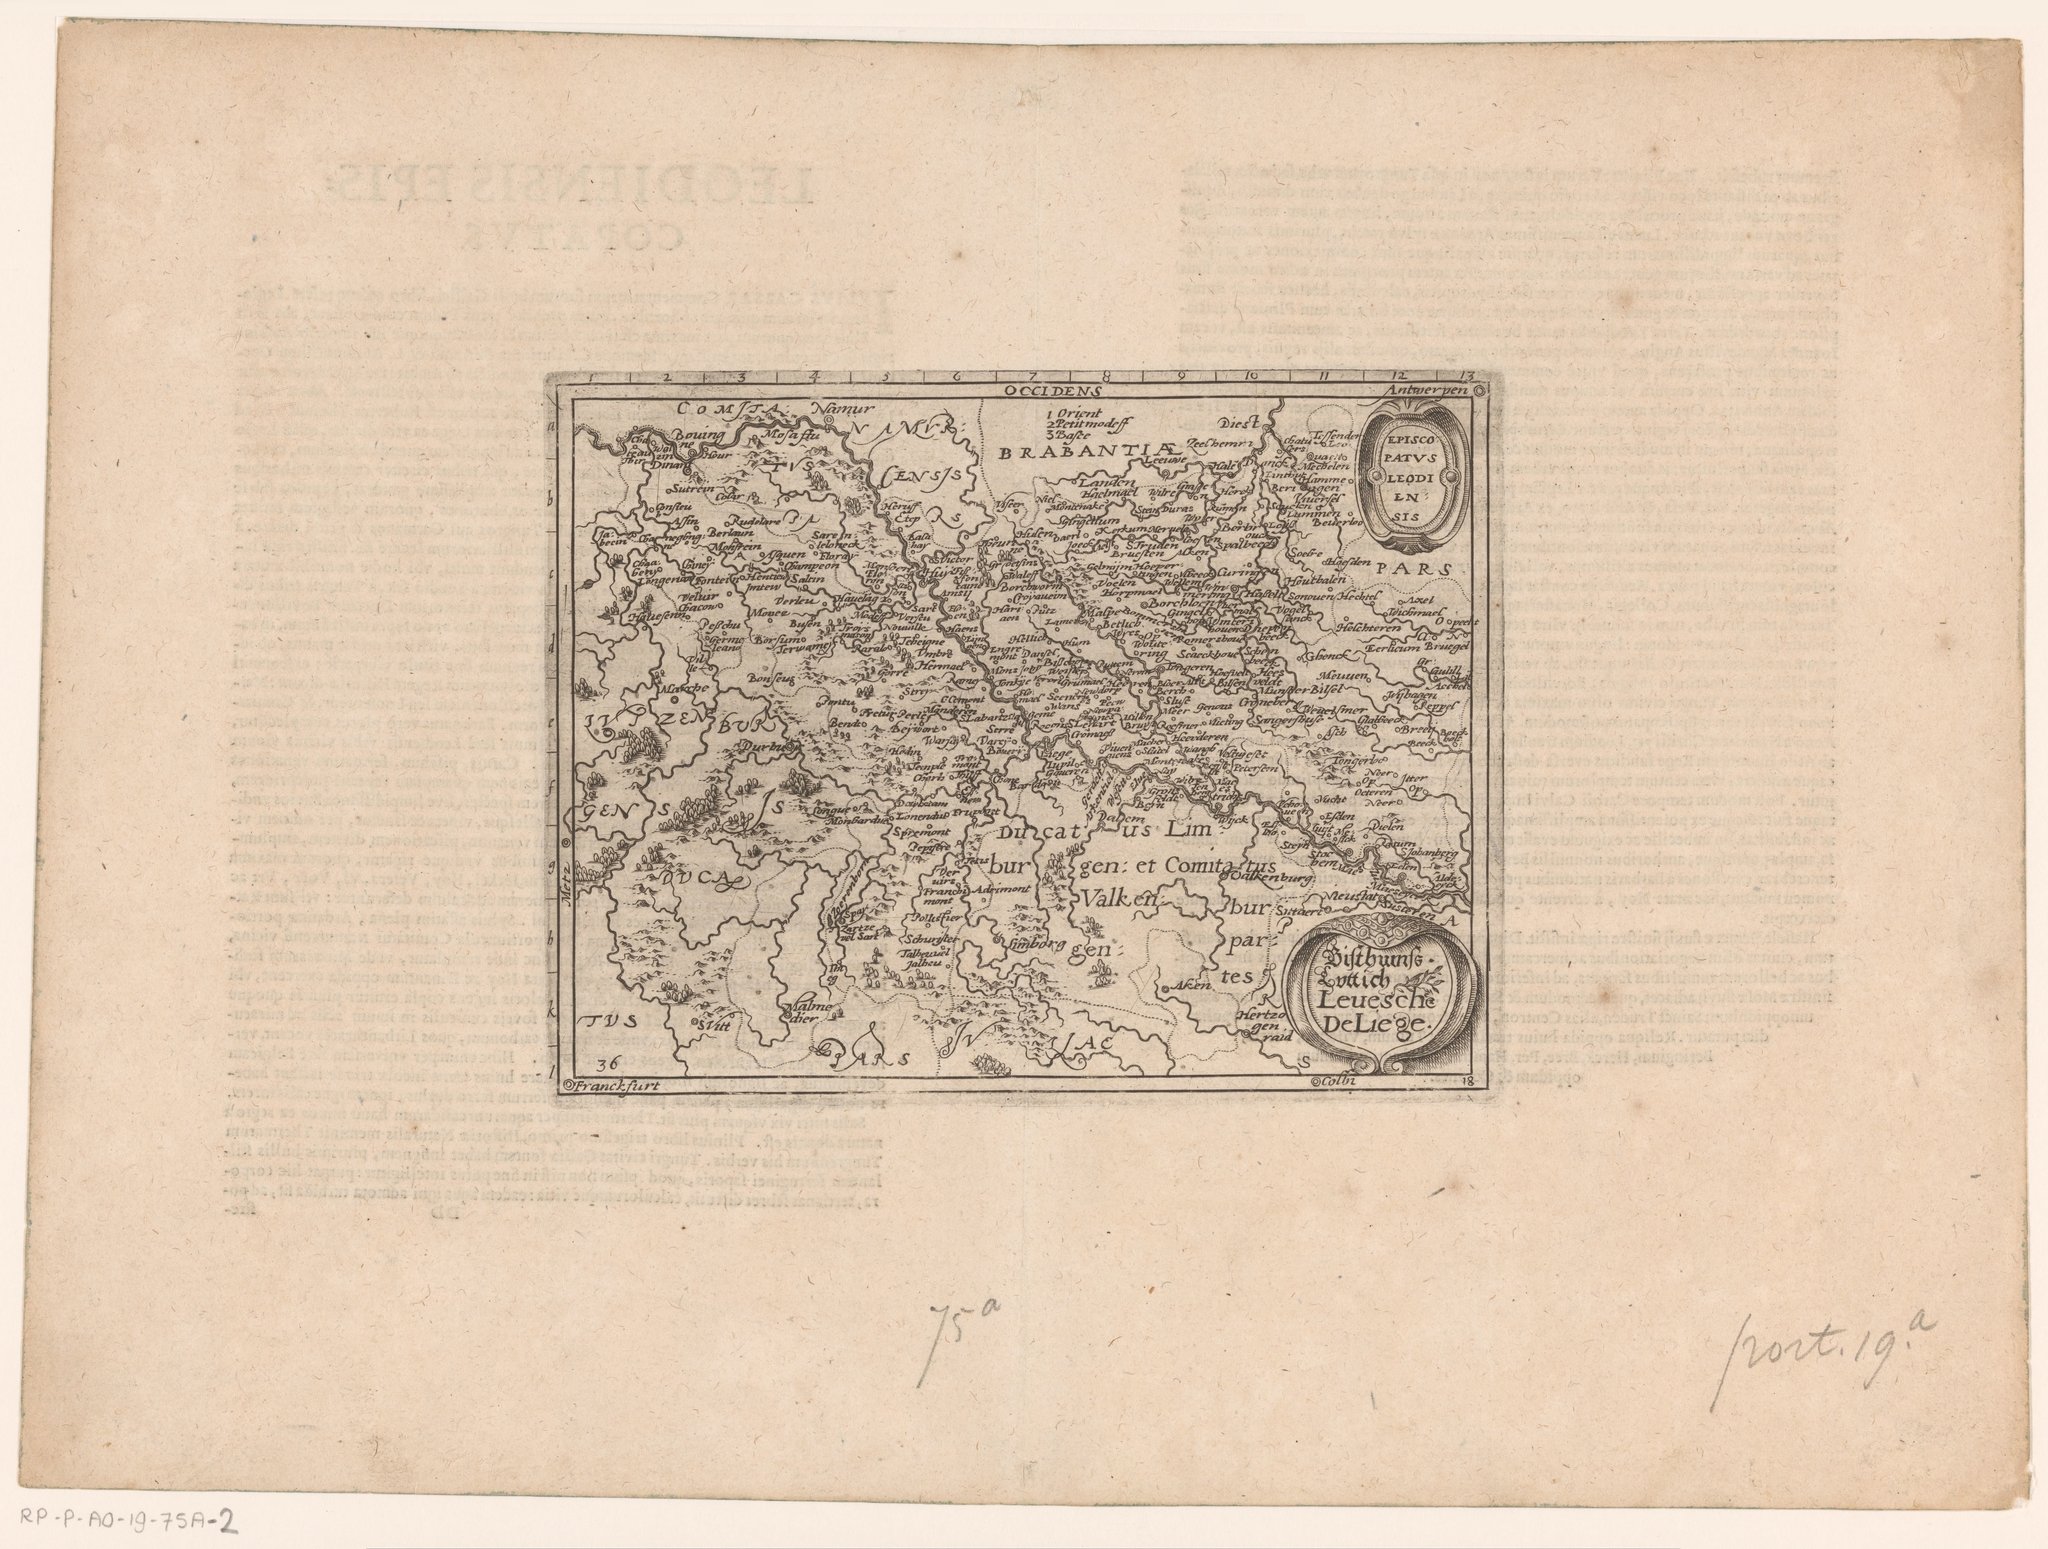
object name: print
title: Kaart van het prinsbisdom Luik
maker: frans hogenberg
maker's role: print maker, publisher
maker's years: 1538-1590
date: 1598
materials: paper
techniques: engraving, letterpress printing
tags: maps of separate countries or regions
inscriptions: collector's mark: Lugt 2228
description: Kaart van het prinsbisdom Luik. Rechts- en linksboven titelcartouches. De kaart is voorzien van een zoekrooster. Linksonder genummerd: 36. Met Latijnse tekst op verso.